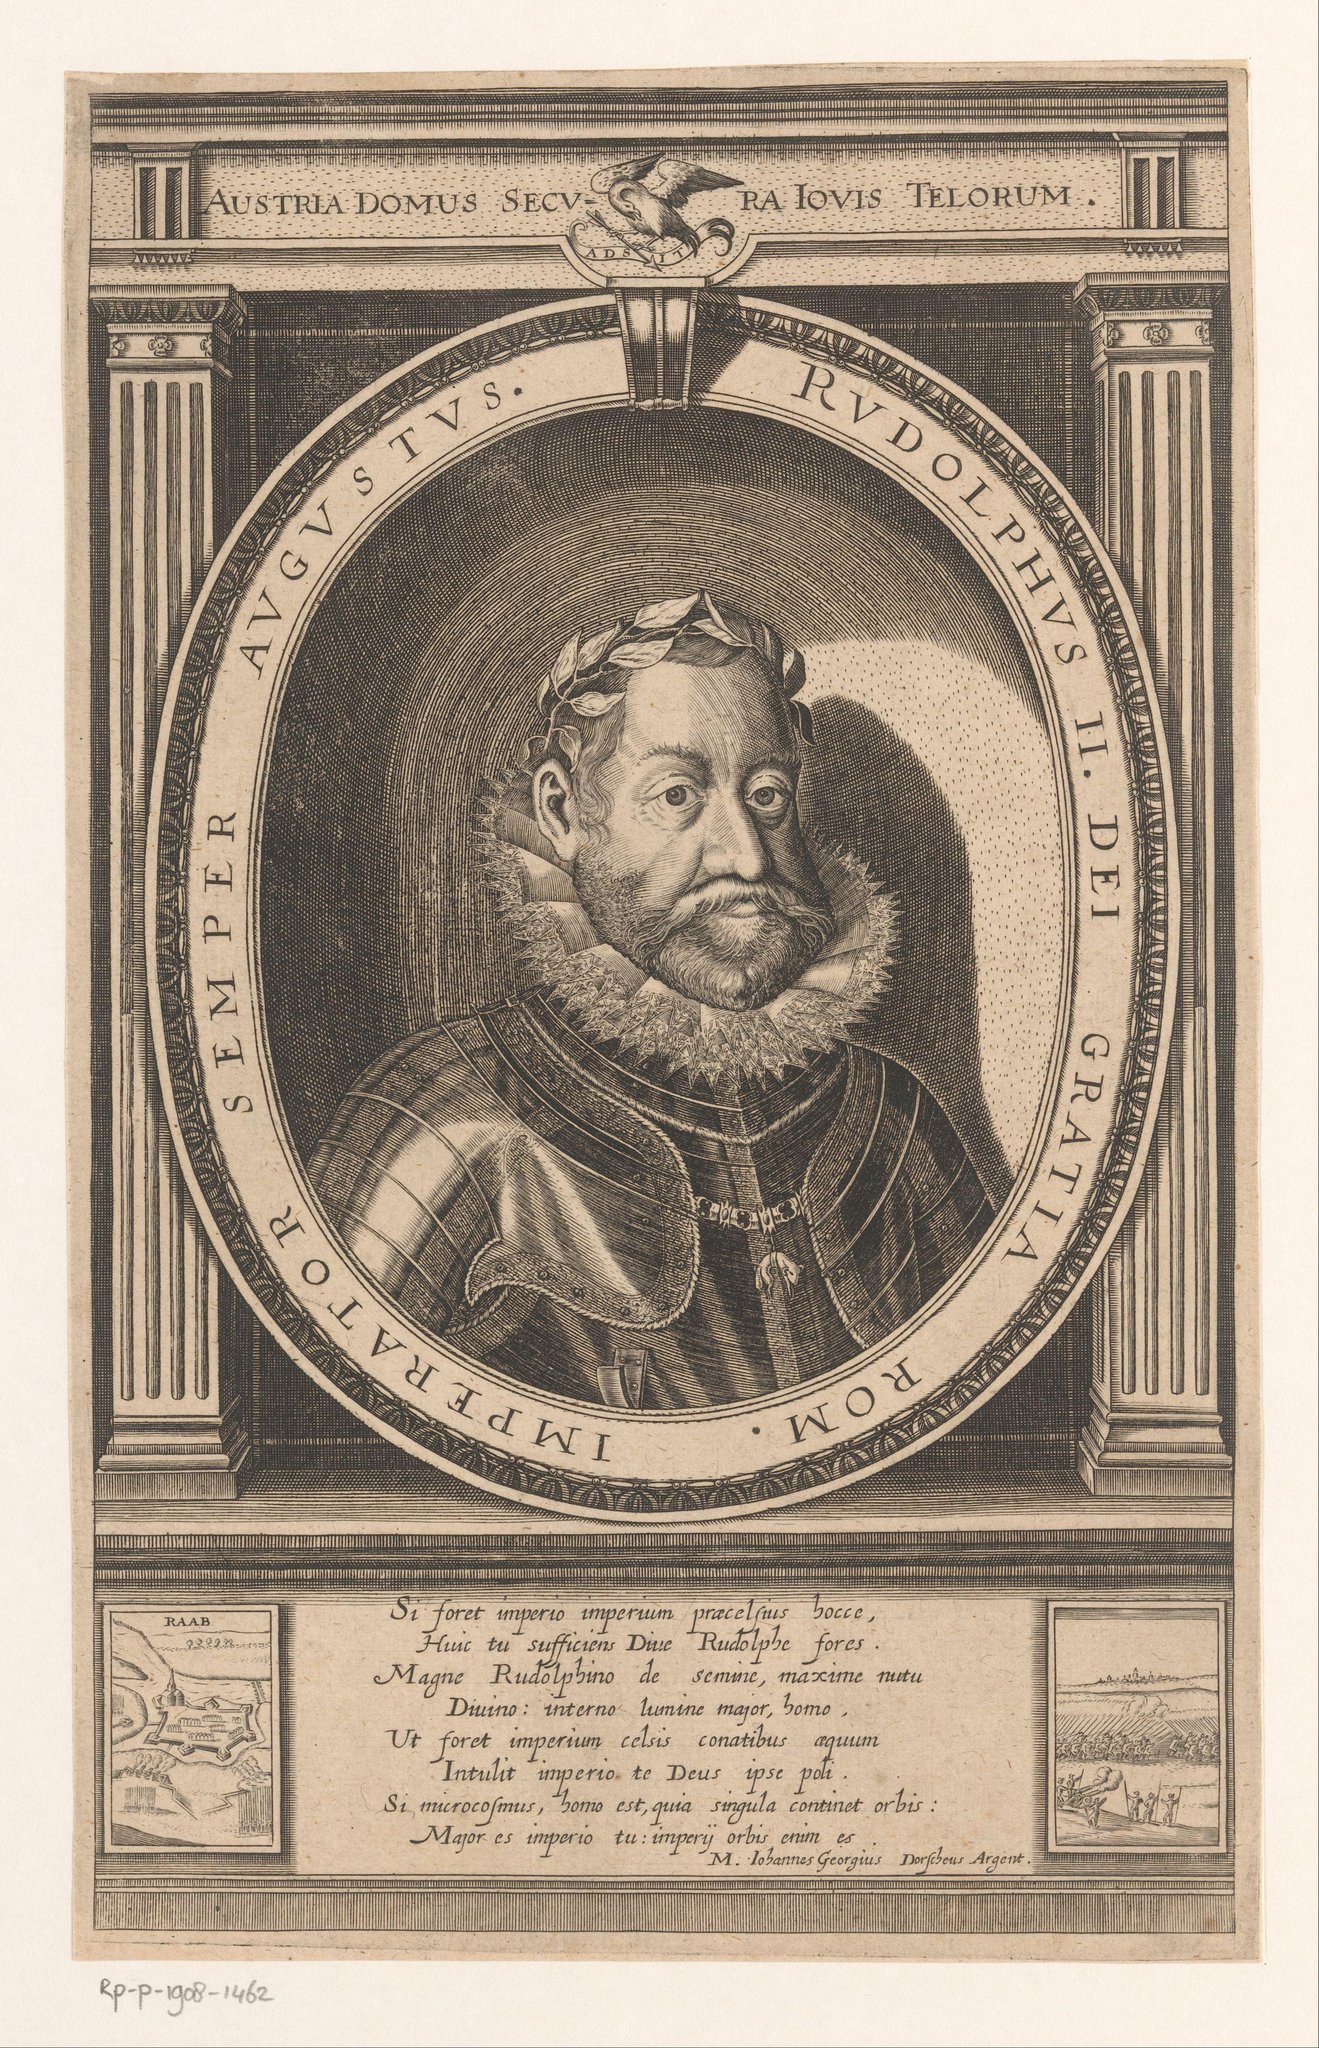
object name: book illustration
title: Portret van Rudolf II van Habsburg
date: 1638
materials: paper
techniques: engraving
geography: straatsburg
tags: vienna, rudolf ii van habsburg (duits keizer), historical persons, battle, emperor, knighthood order of the golden fleece - insignia of a knighthood order, e.g.: badge, chain (with name of order), crowning with laurel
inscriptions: collector's mark: Lugt 2228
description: Prent uit: Ammon, Johannes. Monumentum sepulcrale ad illustrissimi celsissimique principis ac domini Dn. Mauritij Hassiae Landgravij comitis (...). Frankfurt am Main: Johannes Ammon, 1638.